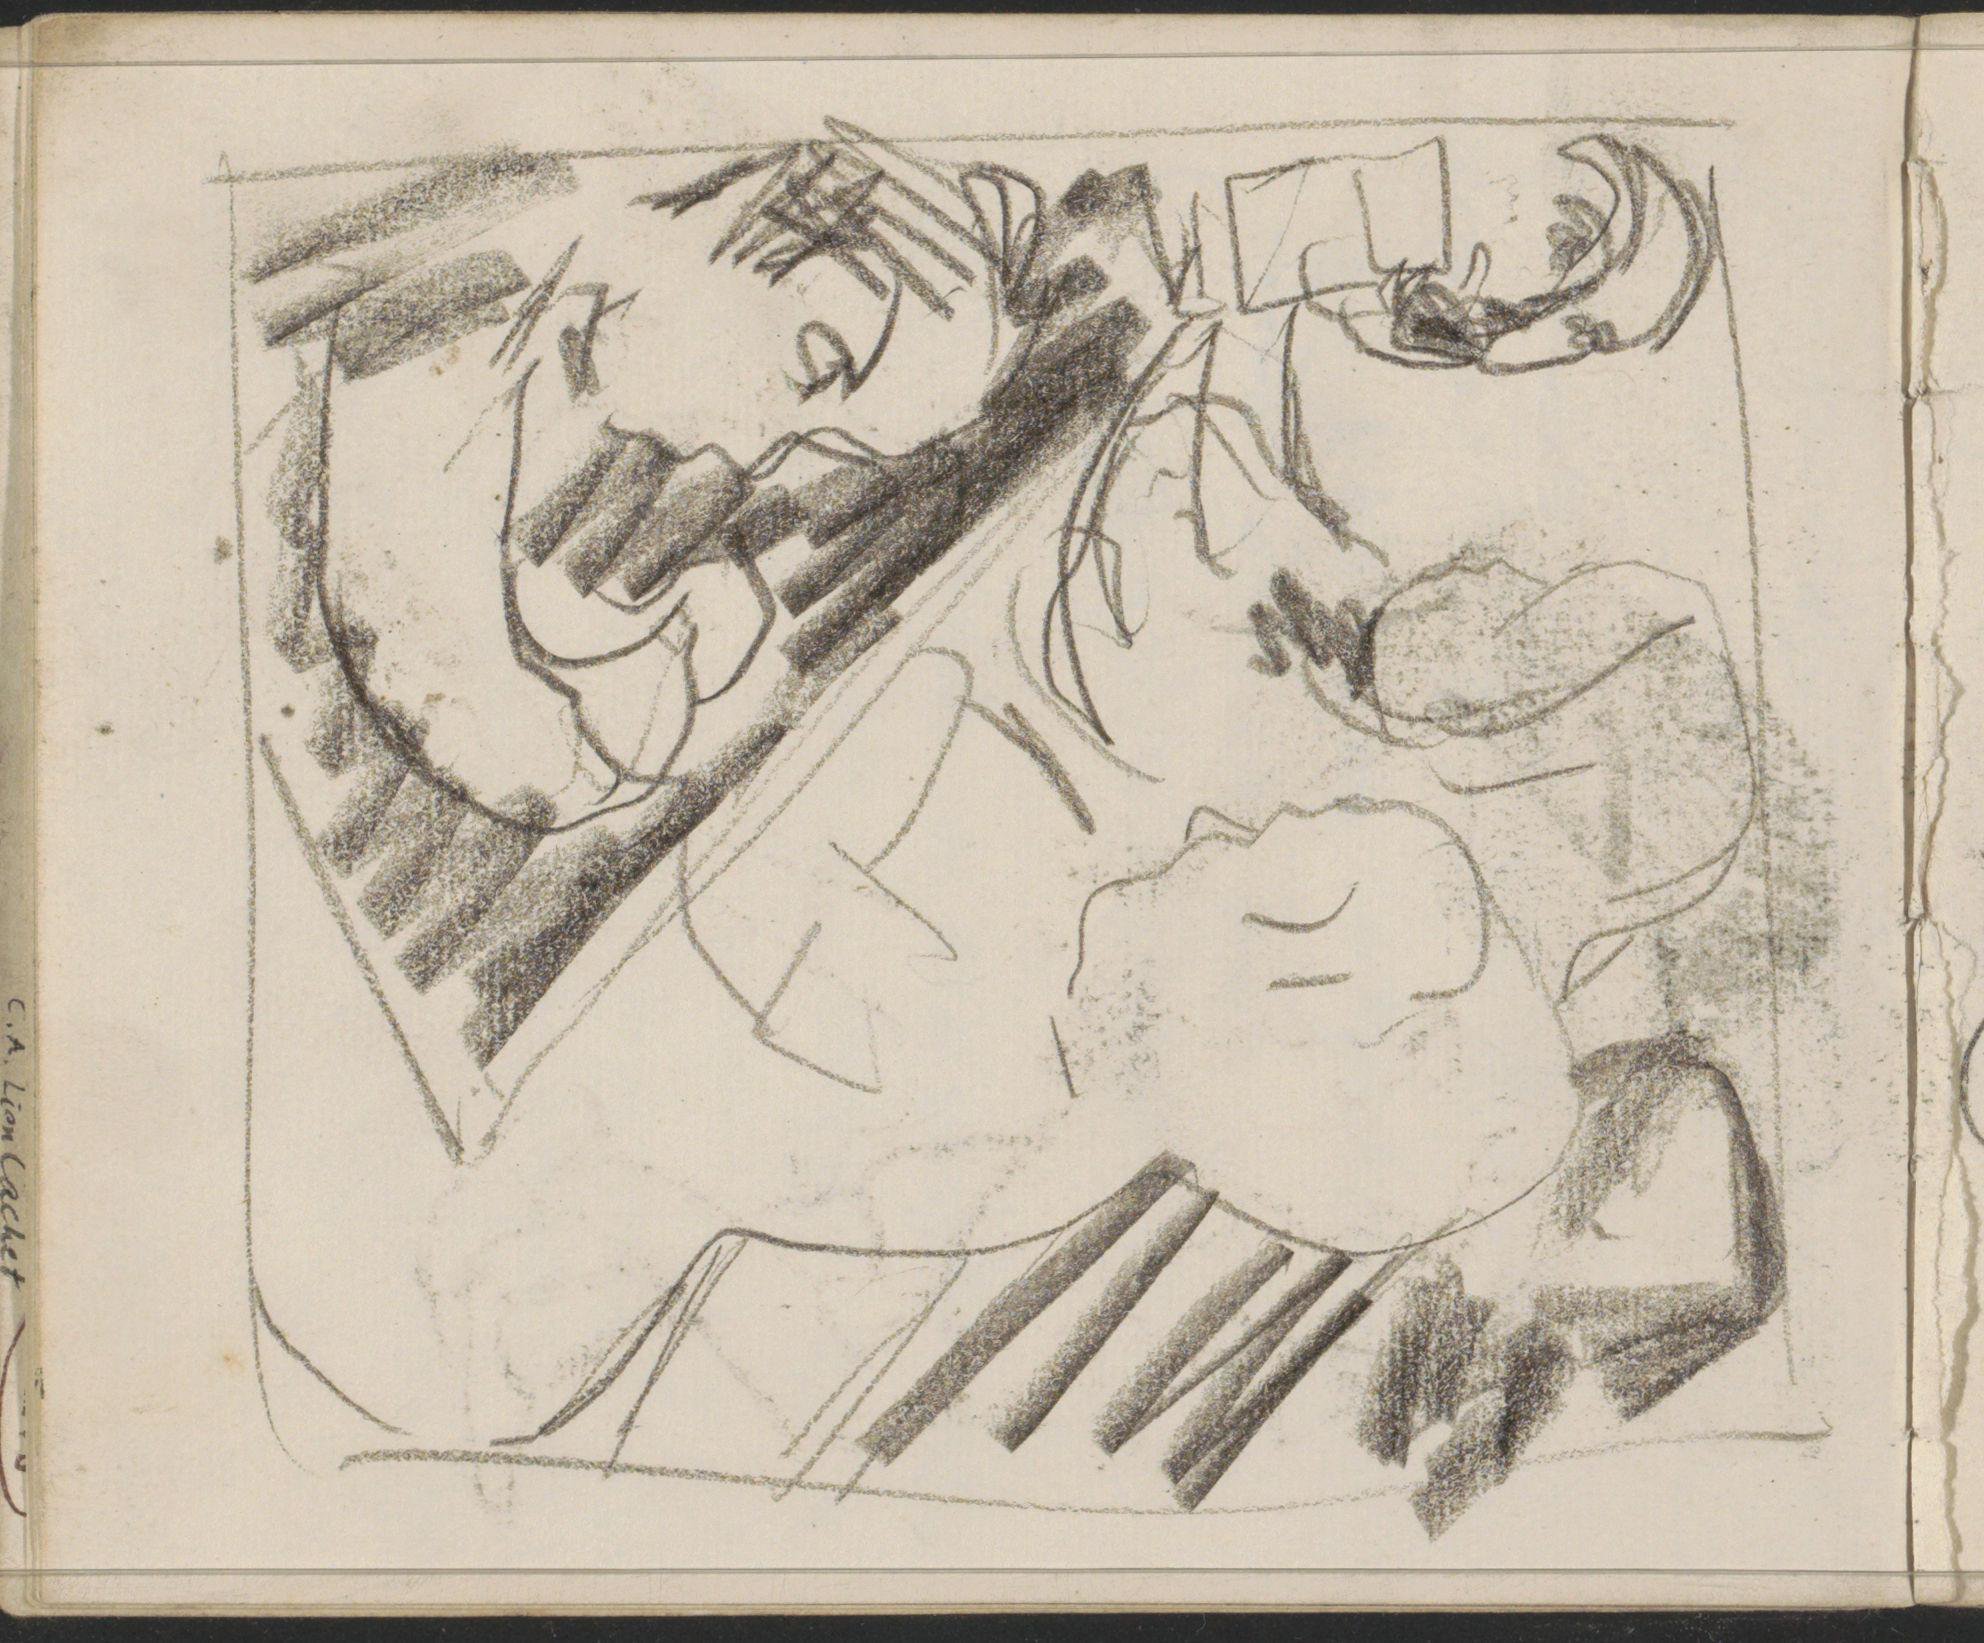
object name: sketchbook leaf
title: Twee zittende kinderen en koppen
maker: carel adolph lion cachet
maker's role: draughtsman, print maker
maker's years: 1864-1945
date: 1895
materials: chalk, paper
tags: sitting figure, child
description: Blad 4 verso uit een schetsboek met 11 bladen.